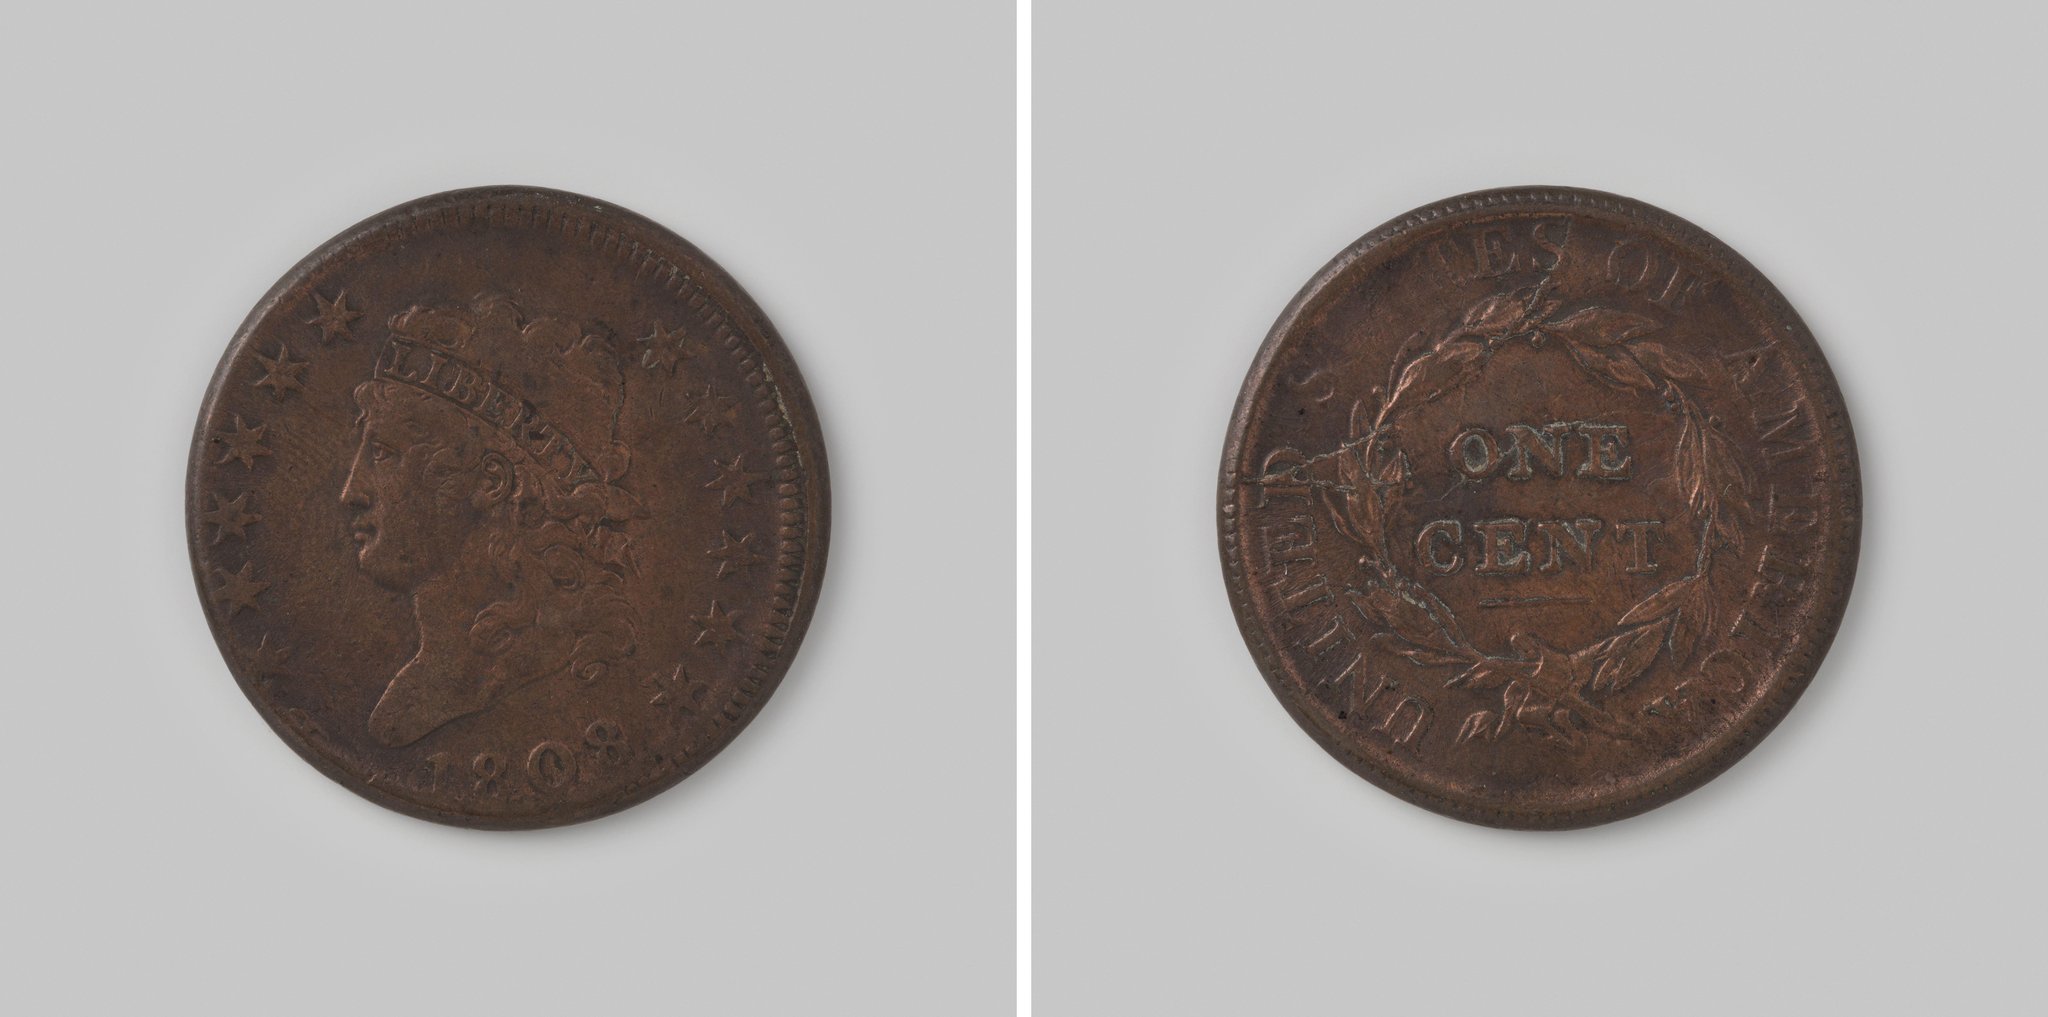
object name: coin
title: Cent uit de Verenigde Staten van Amerika, 1808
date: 1808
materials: copper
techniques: striking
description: Koperen munt. Voorzijde: liberty naar links. Links en rechts van haar een rij sterren. Onderaan jaartal. Keerzijde: tussen een in een cirkel geplooide, met een lint vastgebonden, tak waarde-aanduiding: one cent in twee regels. Gladde rand.